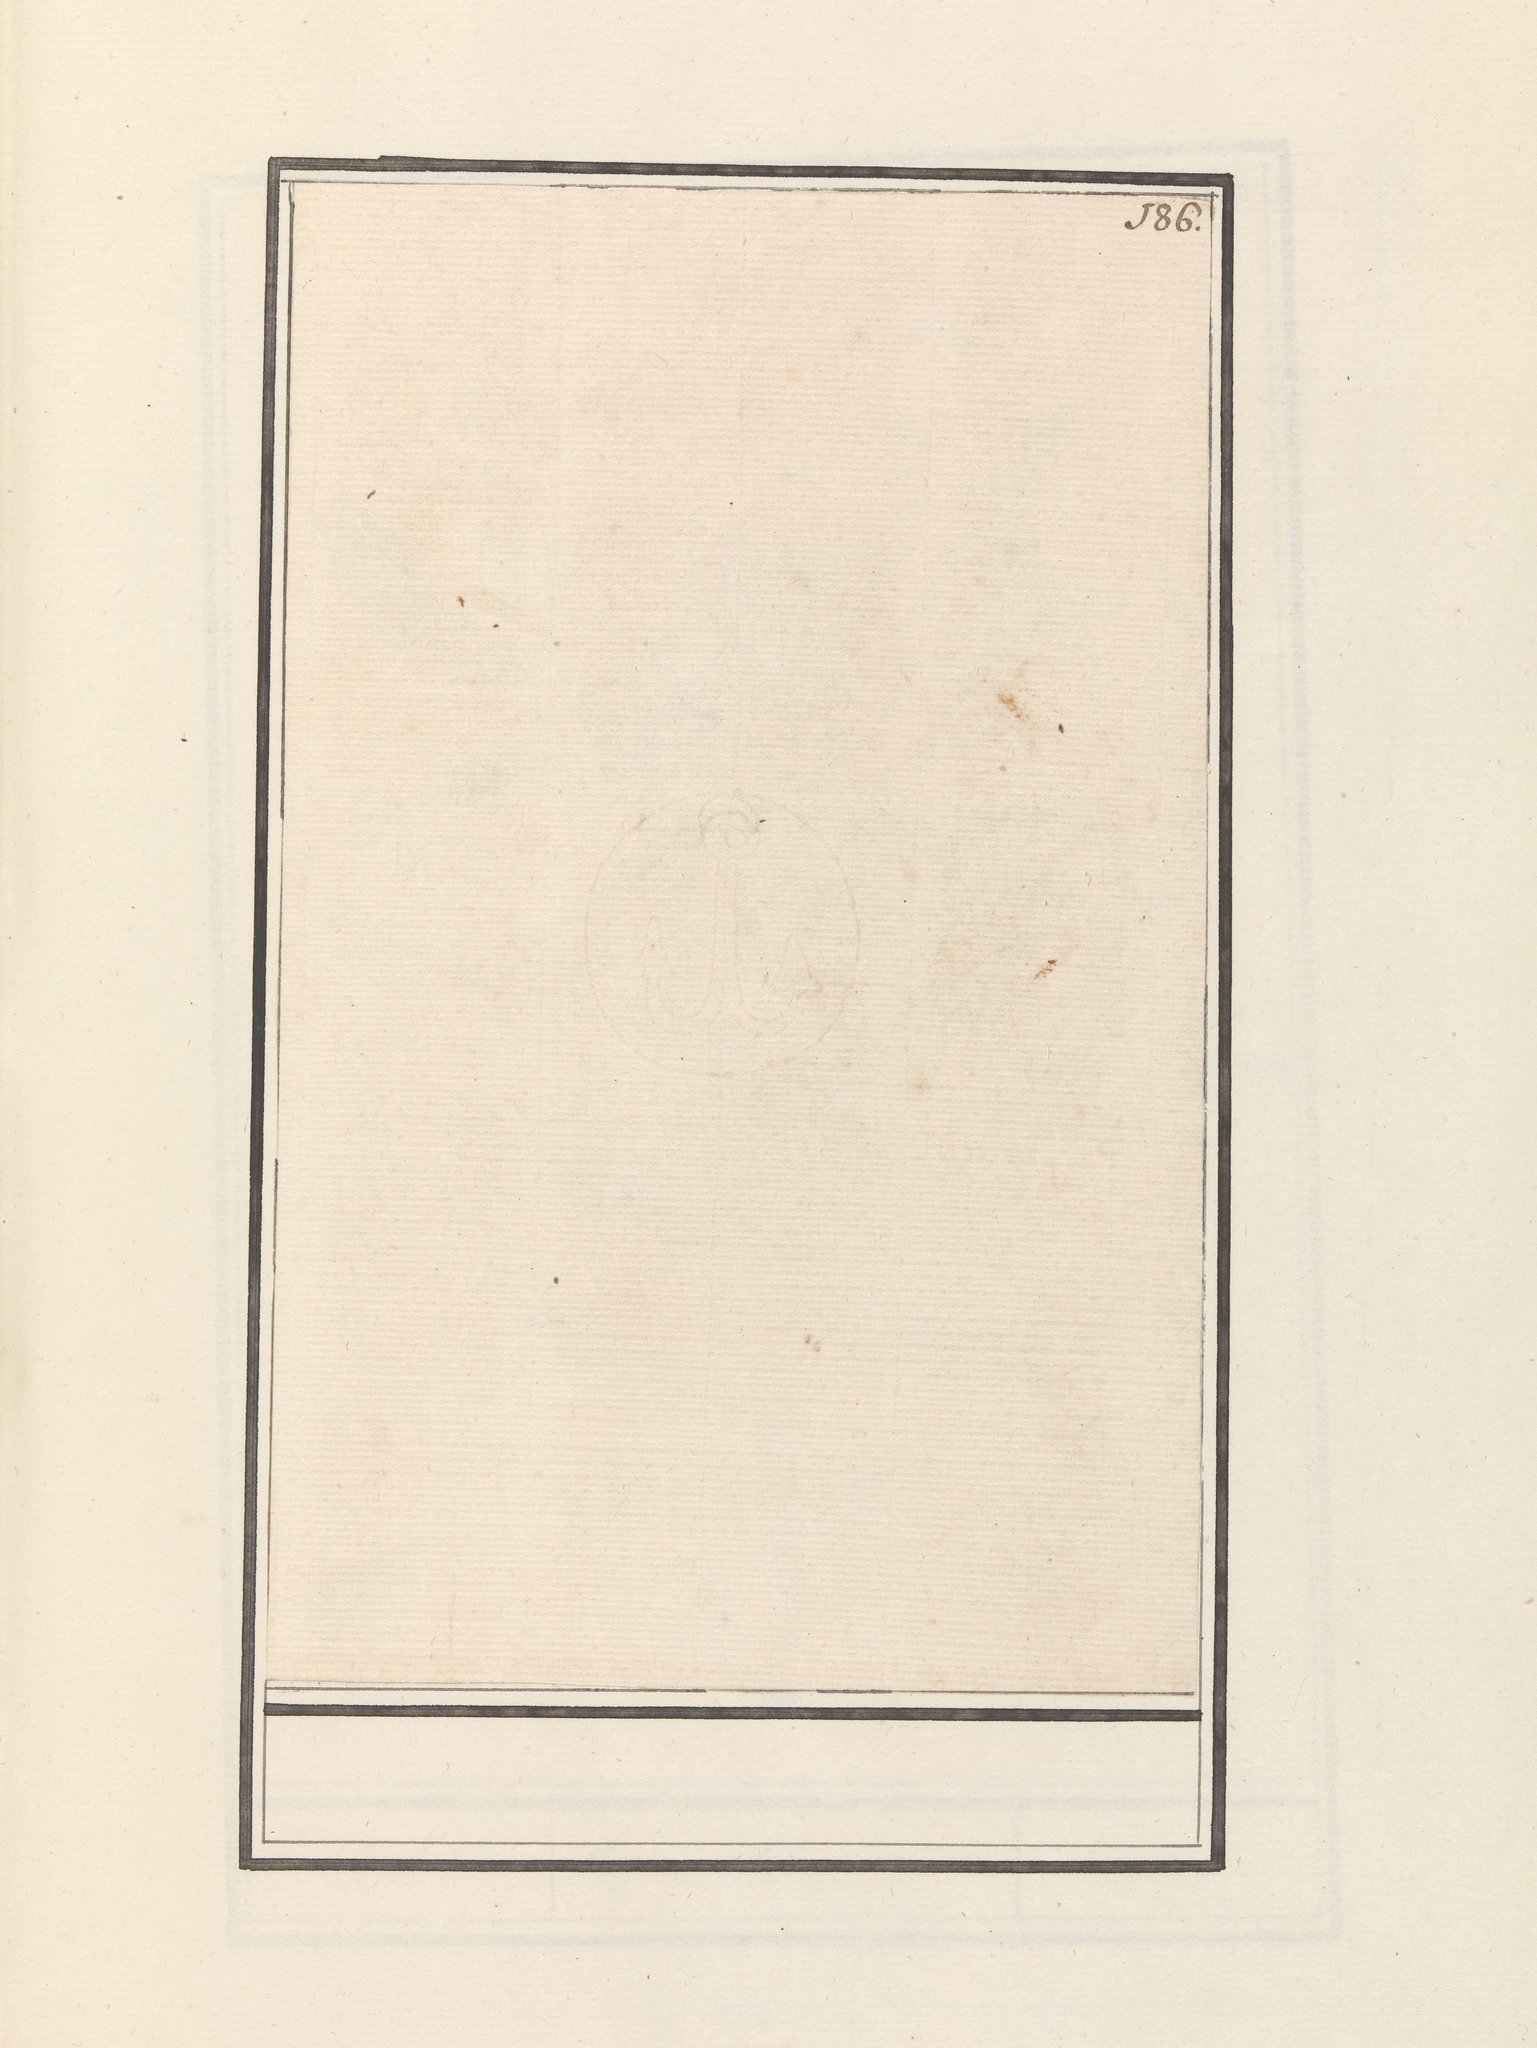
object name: drawing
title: Leeg blad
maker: Anonymous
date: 1809-1814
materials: paper, watercolor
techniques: brush, pen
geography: southern netherlands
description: Leeg blad, opgeplakt binnen omlijsting. Rechtsboven genummerd: 186. Onderdeel van het tweede album met tekeningen van bloemen en planten. Negende van twaalf albums met tekeningen van dieren, vogels en planten bekend rond 1600, gemaakt in opdracht van keizer Rudolf II. Met toelichting in Nederlands, Latijn en Frans.